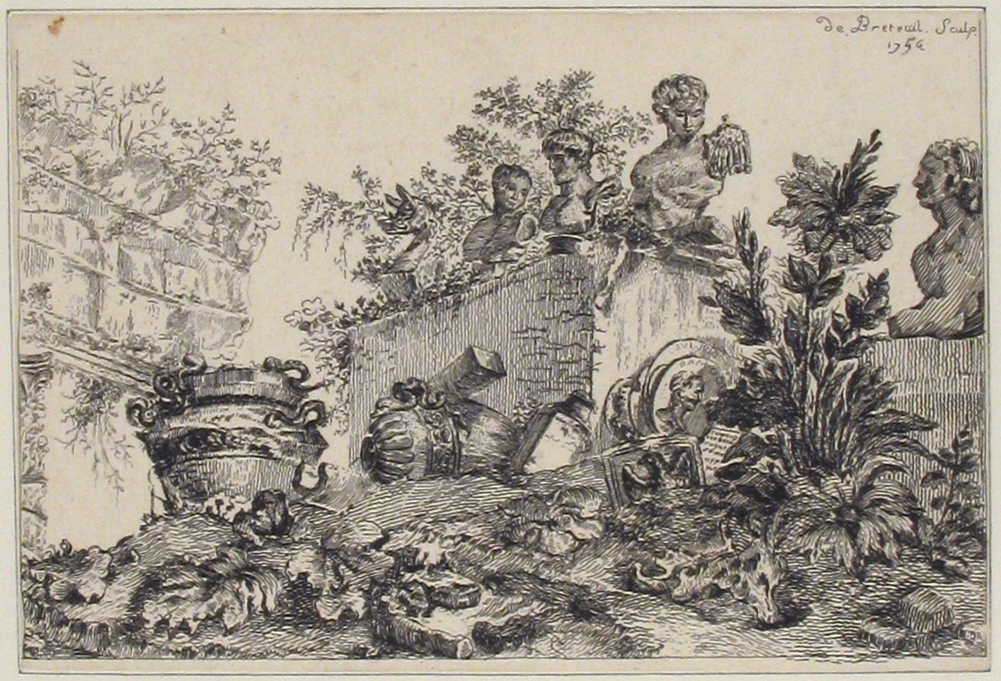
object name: print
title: Landscape with Ruins of Statues and Vases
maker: comte de jacques laure breteuil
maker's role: artist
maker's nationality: french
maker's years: 1730-1750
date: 1746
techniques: etching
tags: ruins,heads,vases